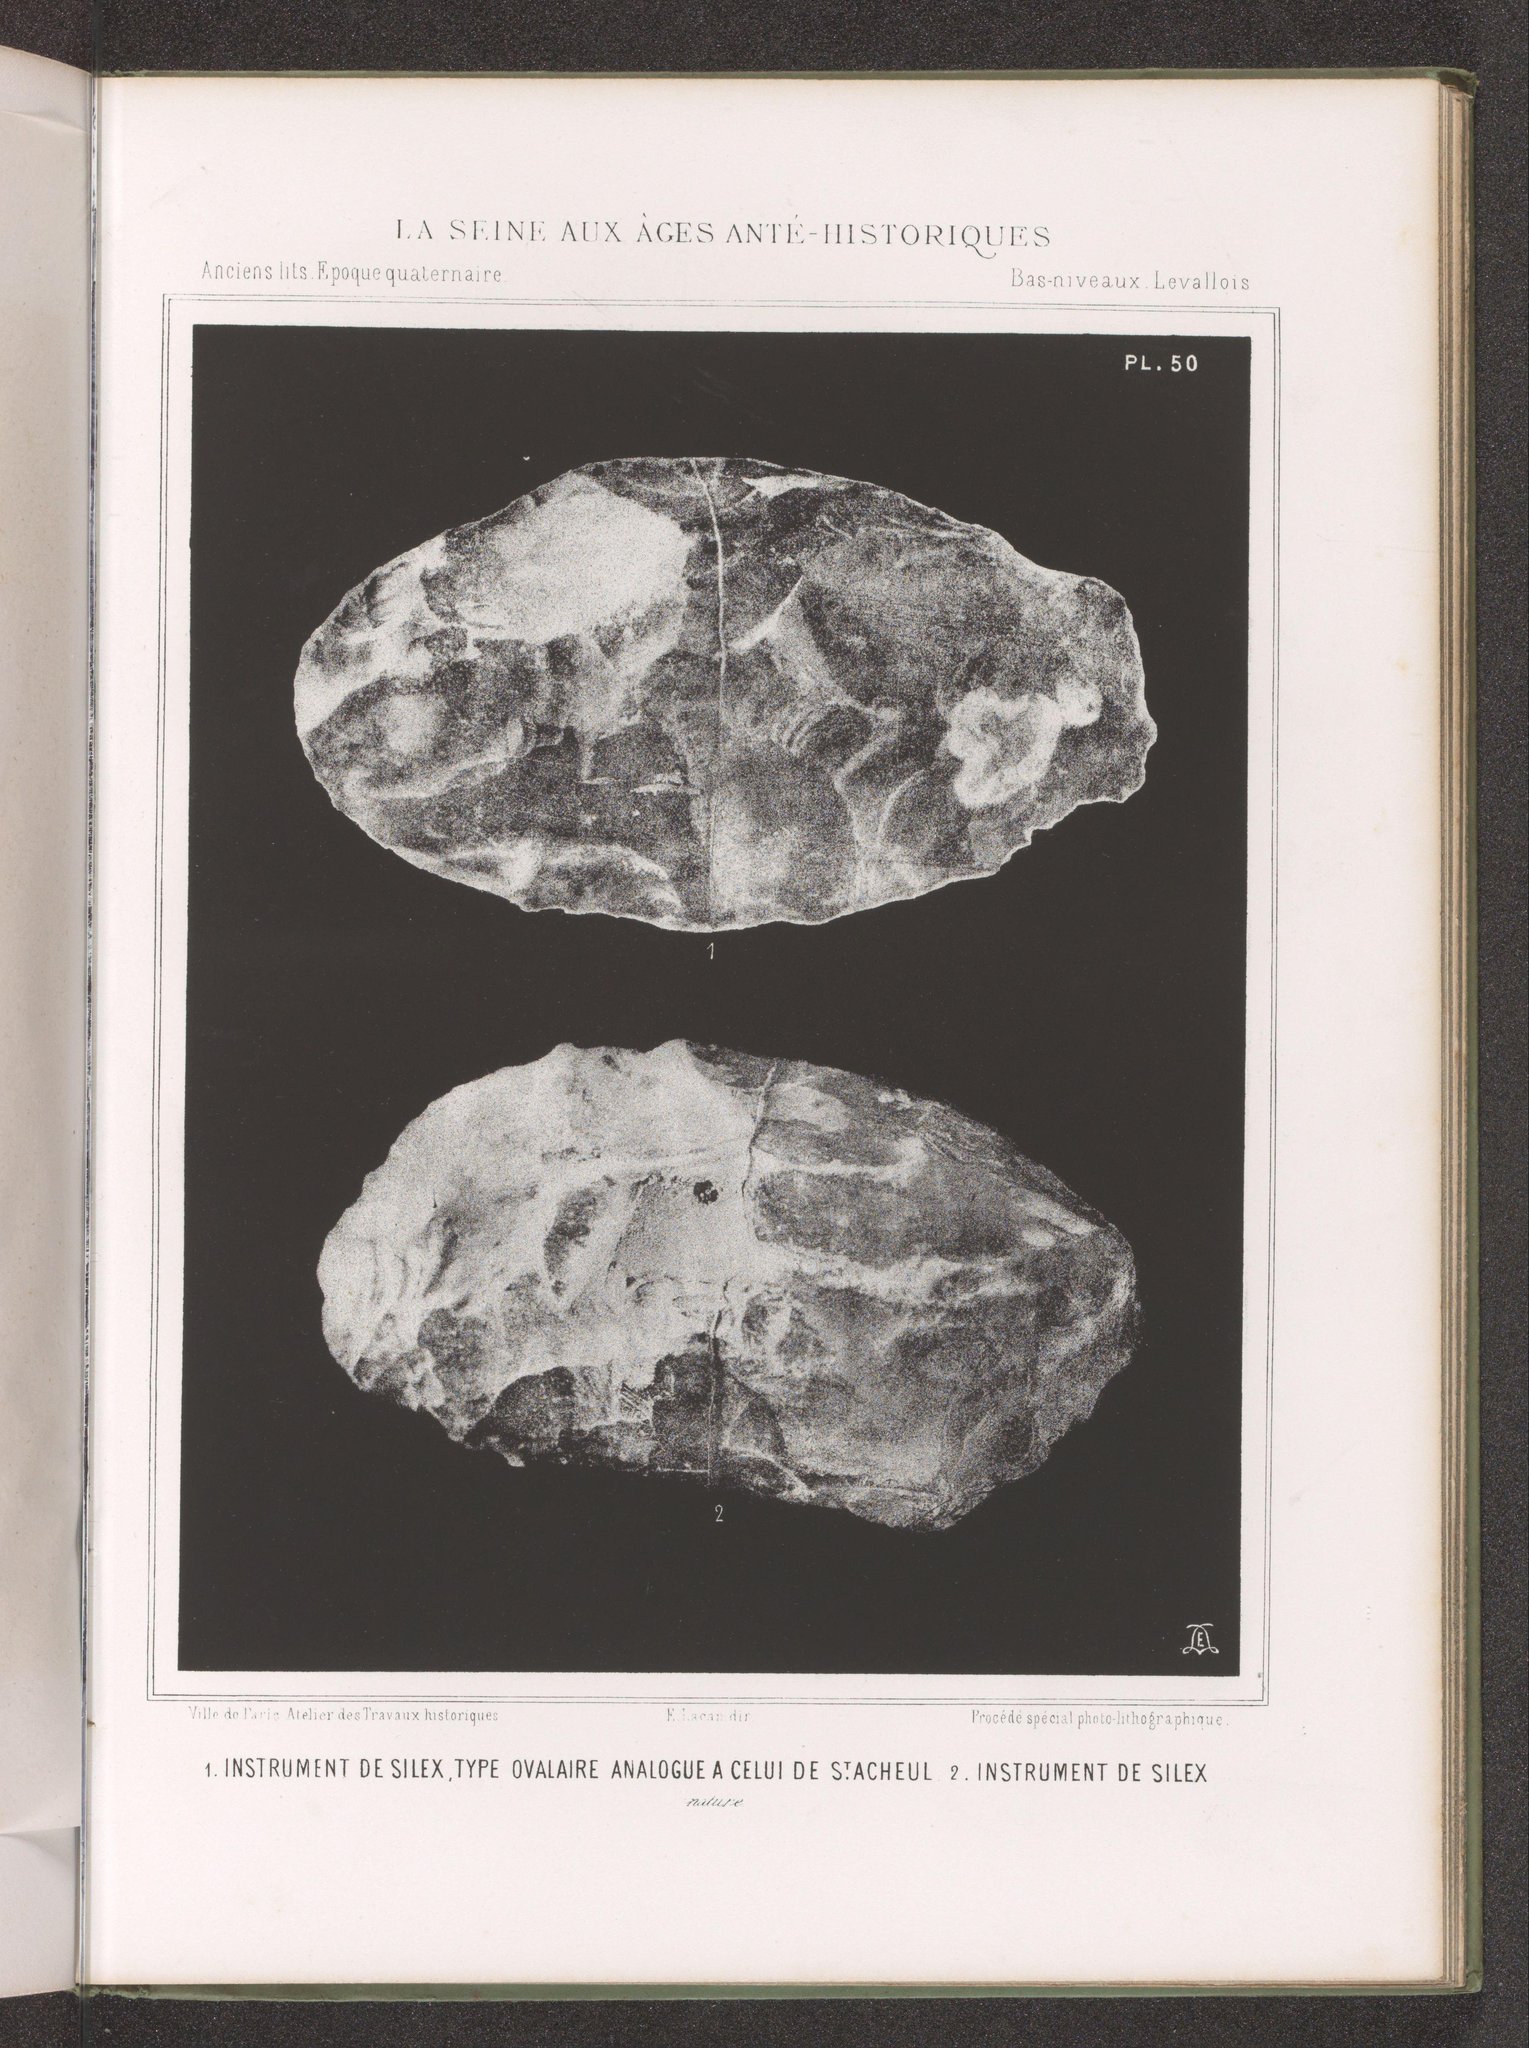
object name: photomechanical print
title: Instrumenten van vuursteen waarvan één vergelijkbaar met een vondst in Saint-Acheul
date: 1860-1869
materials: paper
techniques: photolithography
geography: paris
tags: animals (+ skeleton of an animal), palaeontology, france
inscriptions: monogram: ‘LEL’, inscription: ‘Ville de Paris. Atelier des Travaux historiques. E. Lacan dir. Procédé spécial photo-lithographique.’, number: ‘Pl. 50’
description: In steengroeven nabij Saint-Acheul werden in 1837 vuurstenen gereedschappen gevonden. Dit leidde later tot erkenning van het stenen tijdperk als belangrijke ontwikkelingsfase in de menselijke geschiedenis.